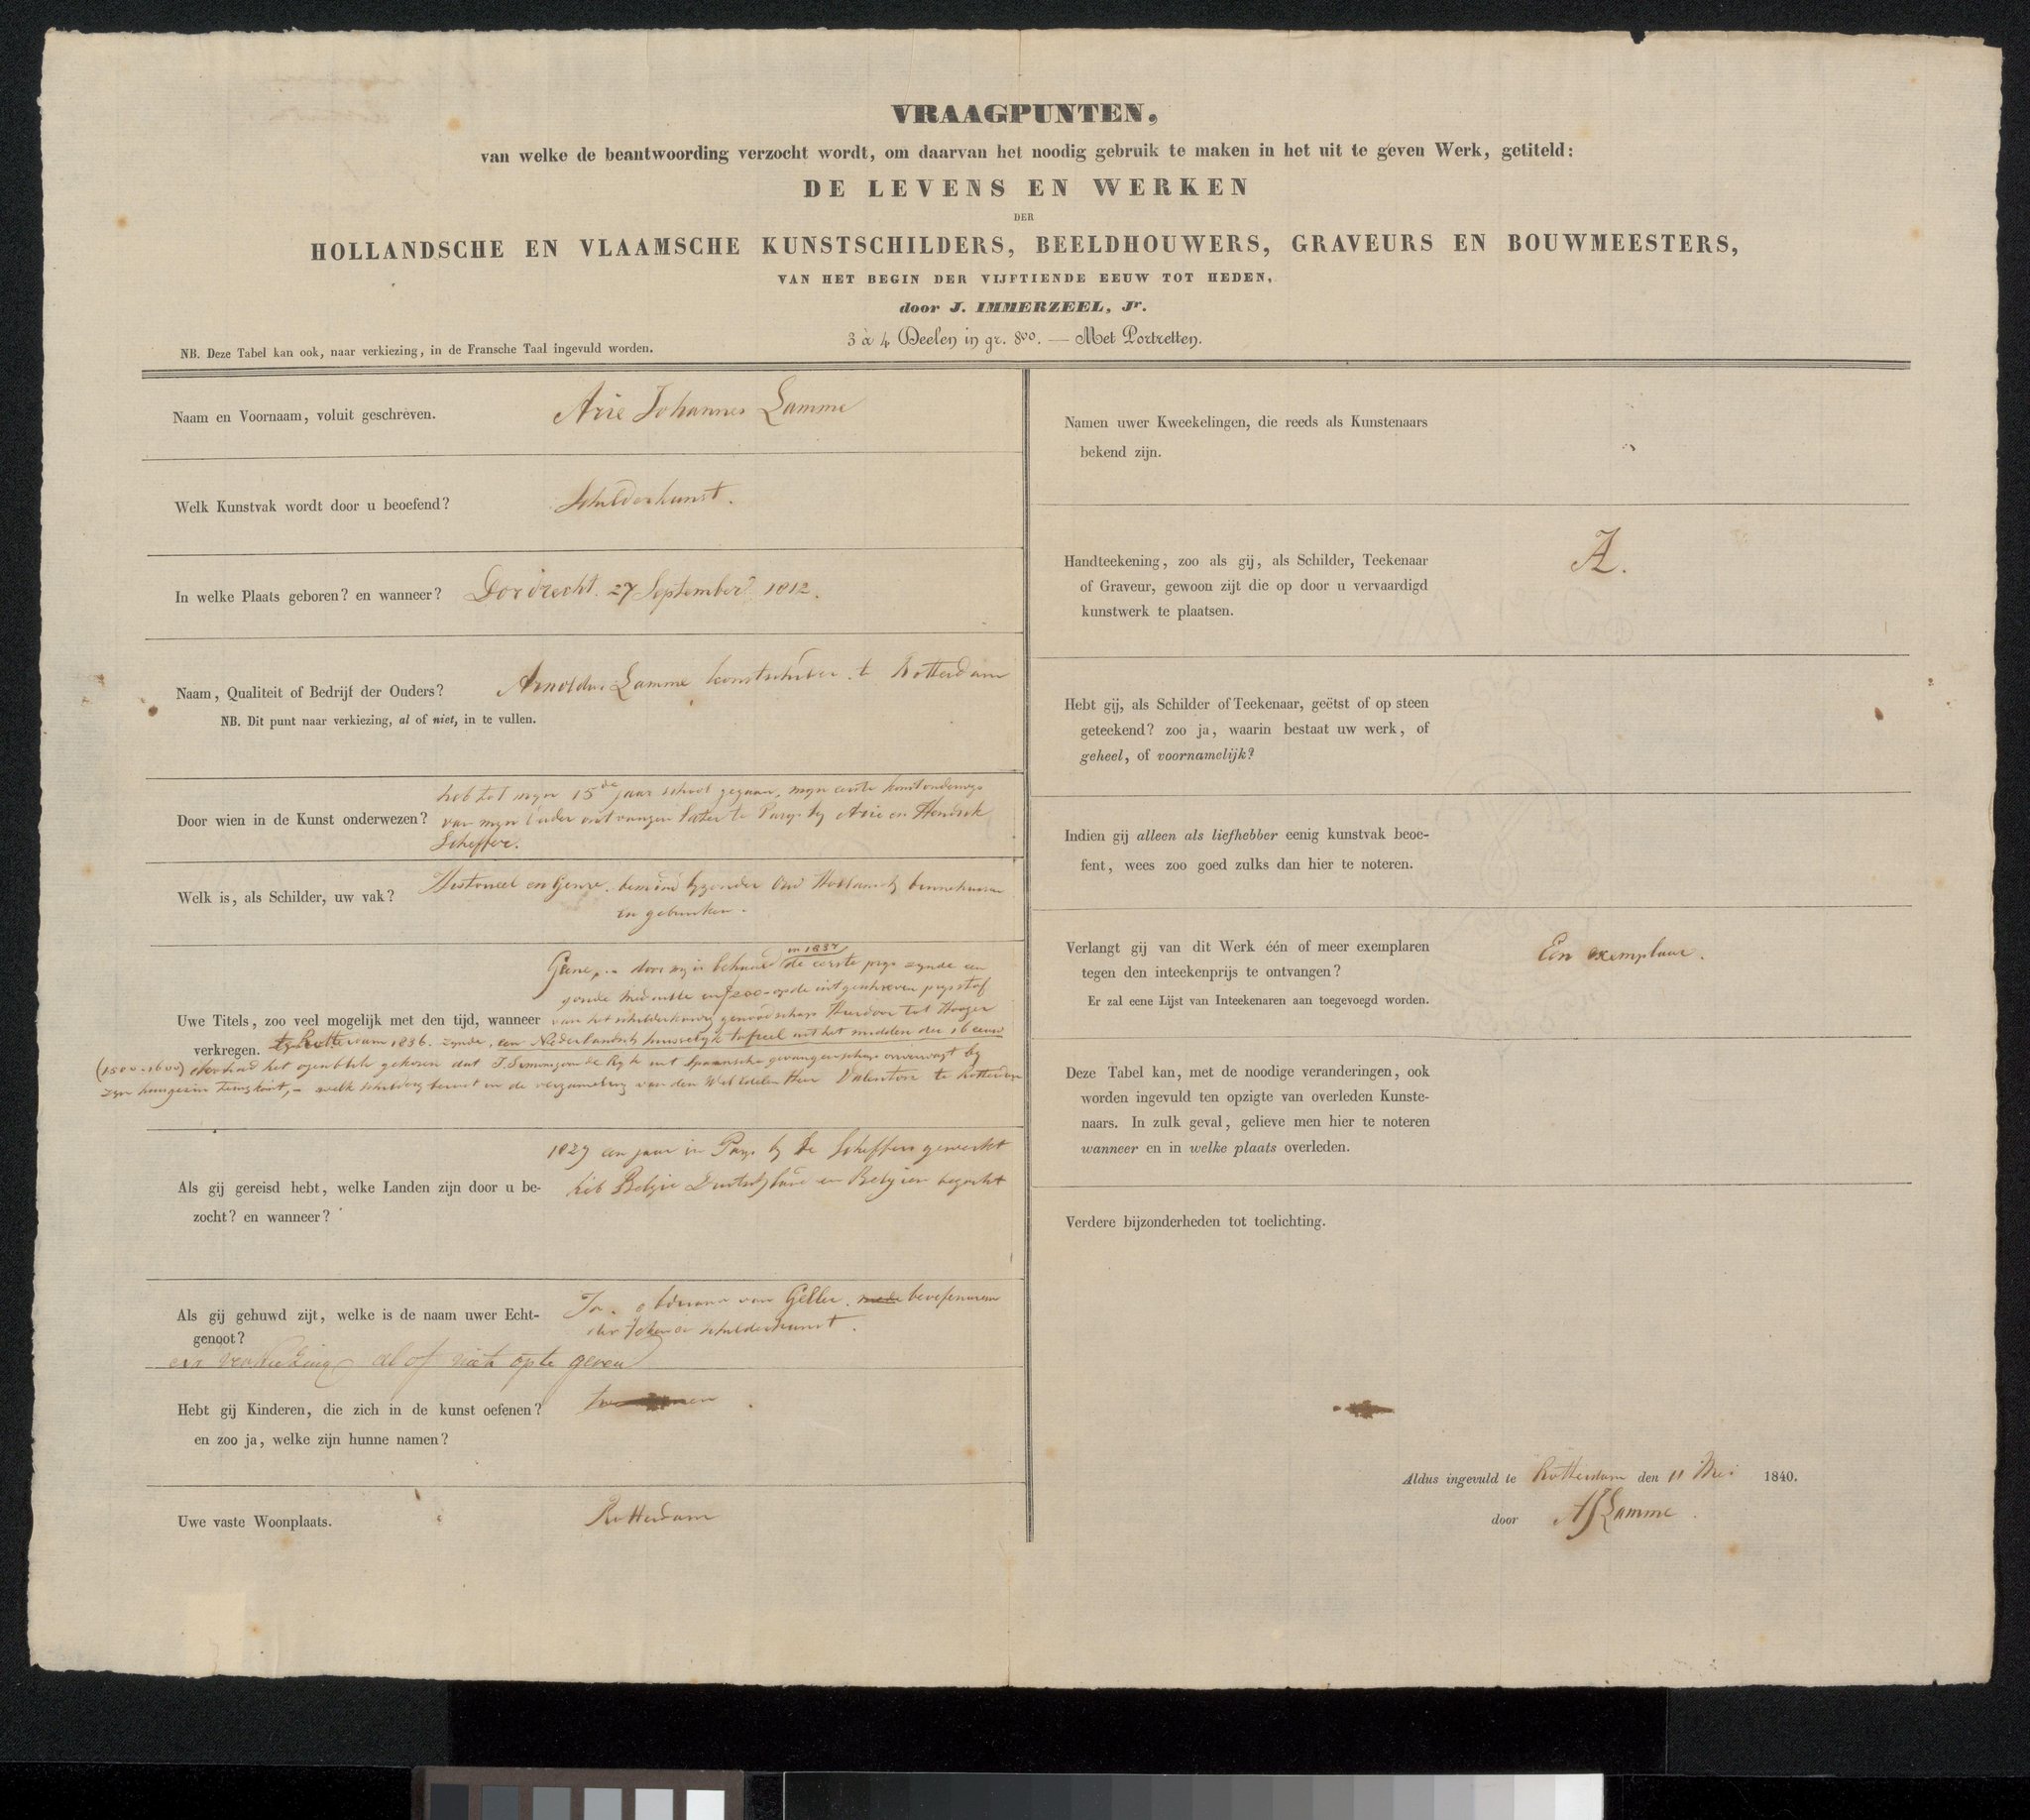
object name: manuscript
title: Enquêteformulier ingevuld door Ary Johannes Lamme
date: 1840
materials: ink, paper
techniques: pen, printing, writing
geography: rotterdam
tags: dordrecht, print maker, draughtsman, ary johannes lamme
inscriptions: watermark, inscription: ‘Vraagpunten,/ van welke de beantwoording verzocht wordt, om daarvan het noodig gebruik te maken in het uit te geven Werk, getiteld: De levens en werken/ der Hollandsche en Vlaamsche kunstschilders, beeldhouwers,/ graveurs en bouwmeesters, van het begin der vijftiende eeuw tot heden/ door J. Immerzeel, Jr.’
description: Opgenomen in: Immerzeel, J. Jr., De levens en werken der Hollandsche en Vlaamsche kunstschilders, beeldhouwers, graveurs en bouwmeesters, van het begin der vijftiende eeuw tot heden, Amsterdam: J.C. van Kesteren, 1842-1843.